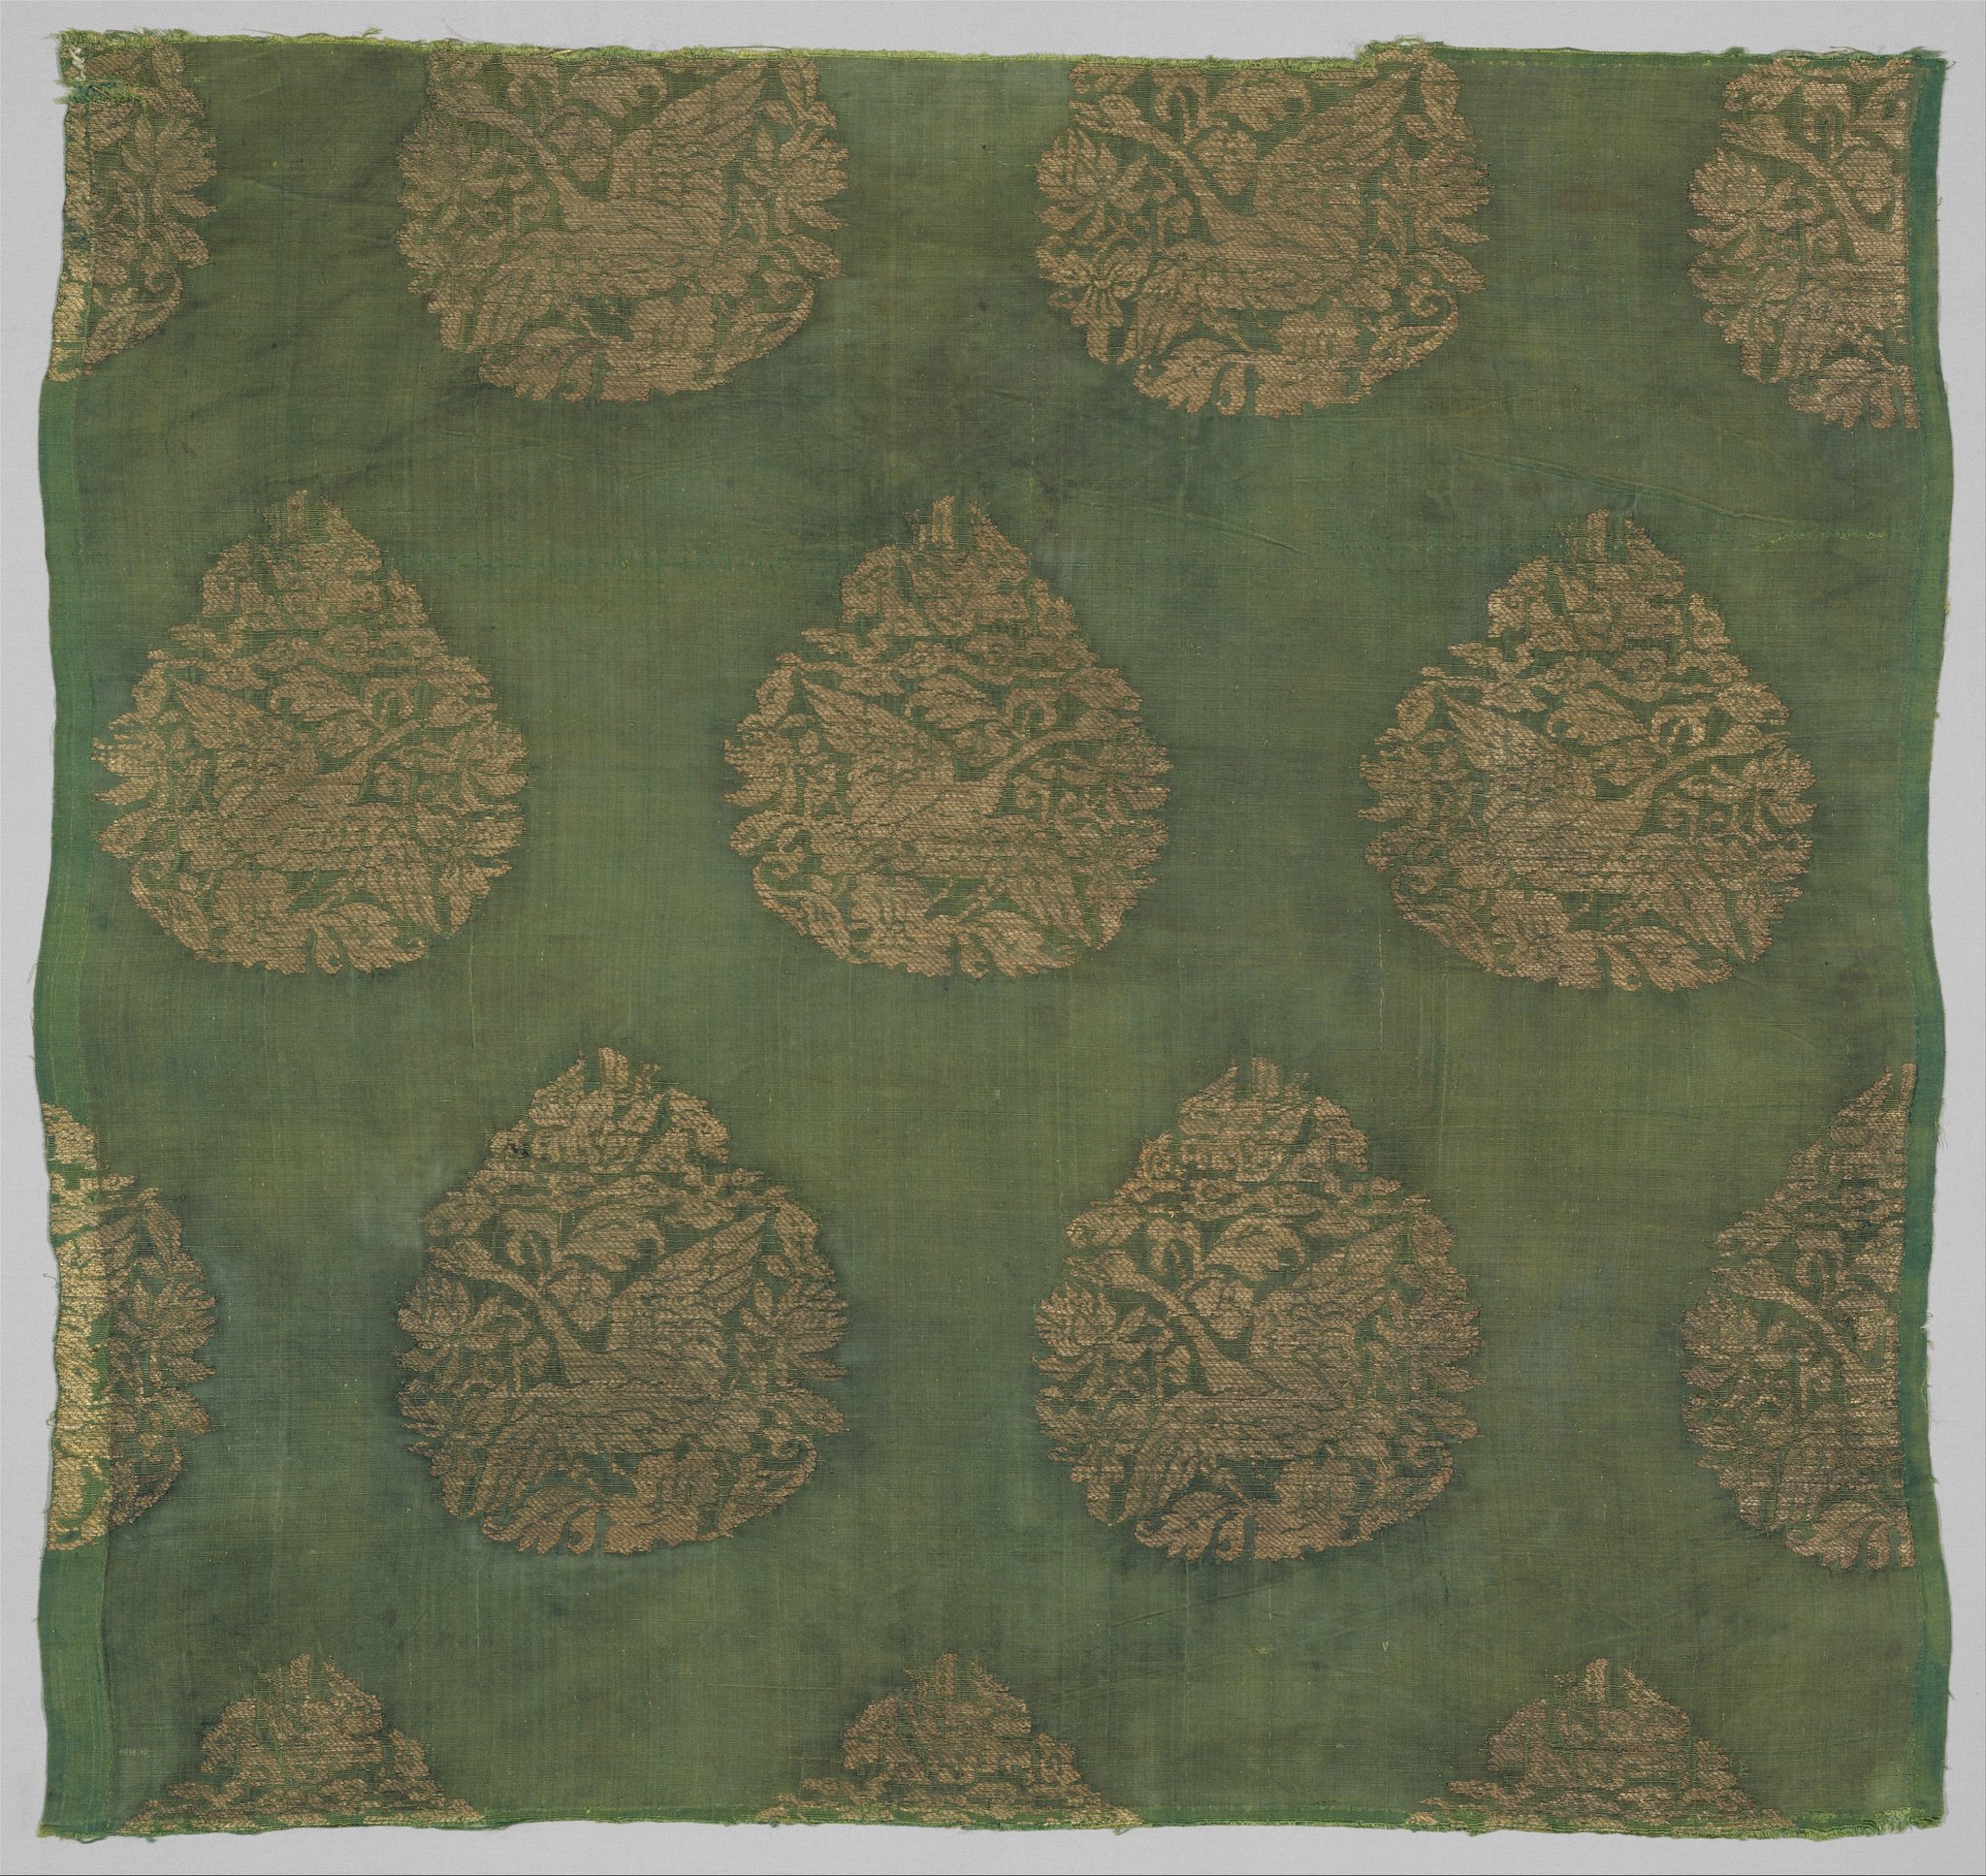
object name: panel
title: Textile with Swan Hunt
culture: chinese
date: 1101-1300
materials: gilt, leather, silk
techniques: brocade, weave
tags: swans